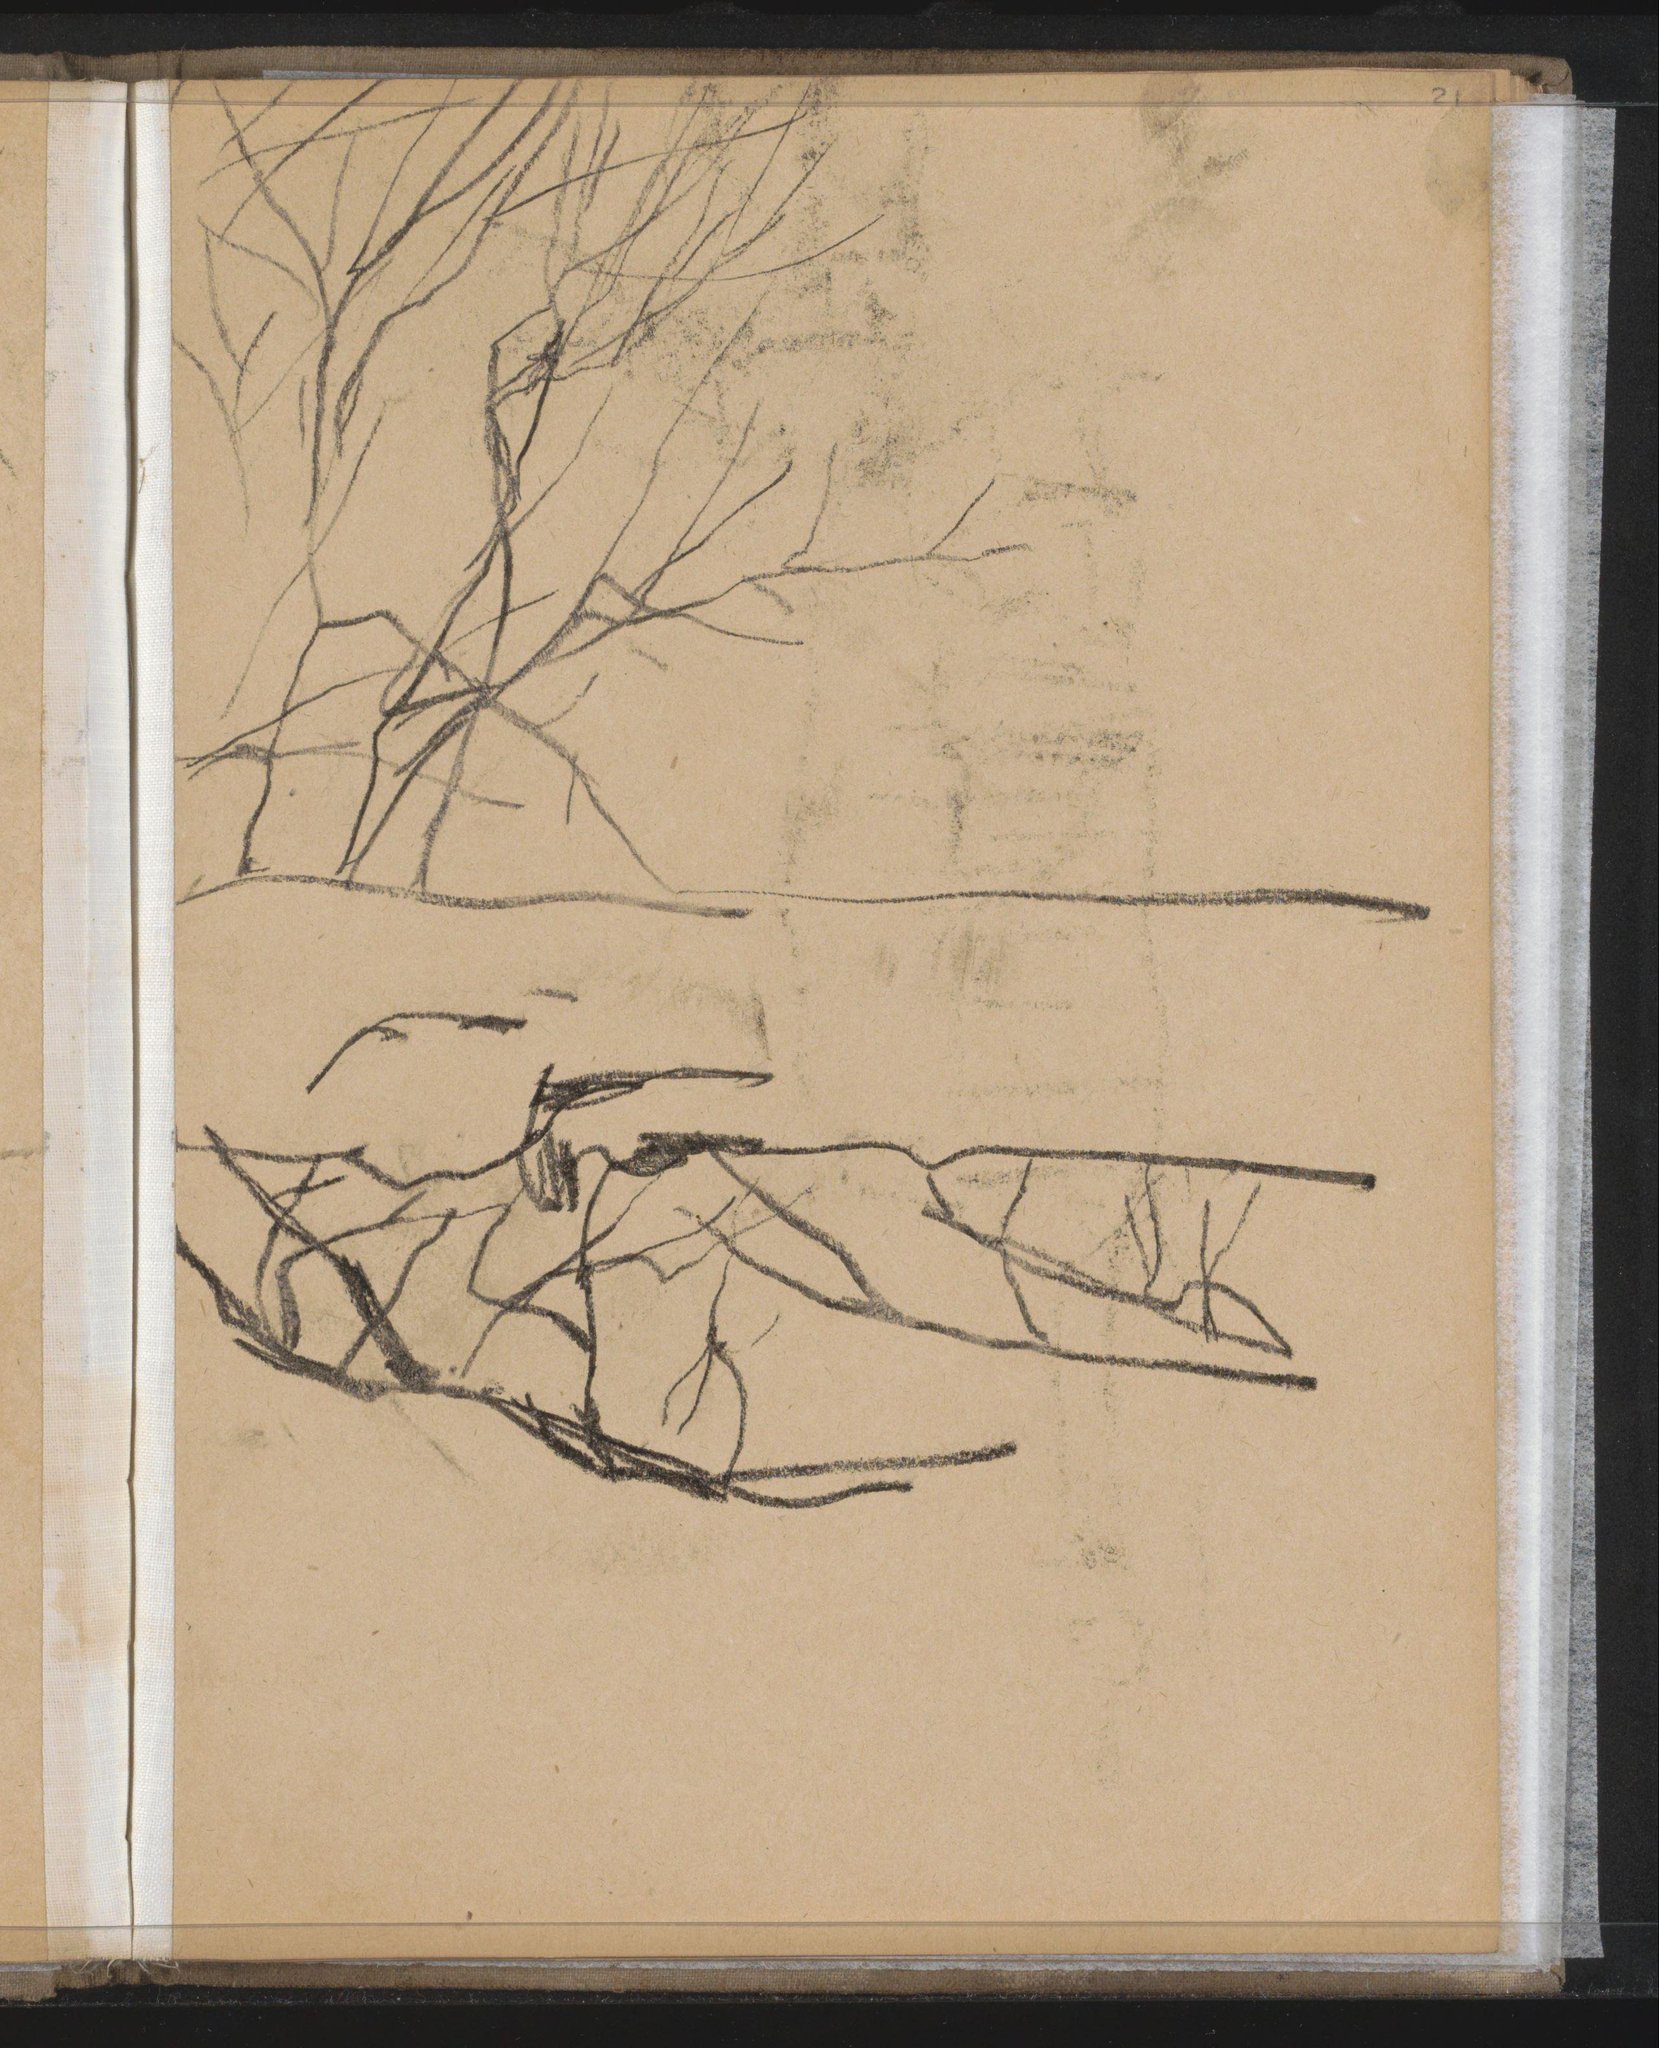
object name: sketchbook leaf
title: Boom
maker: willem witsen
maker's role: draughtsman, painter, print maker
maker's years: 1860-1923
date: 1893-1897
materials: chalk, paper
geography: ede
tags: trees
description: Pagina 21 uit een schetsboek met 28 bladen.